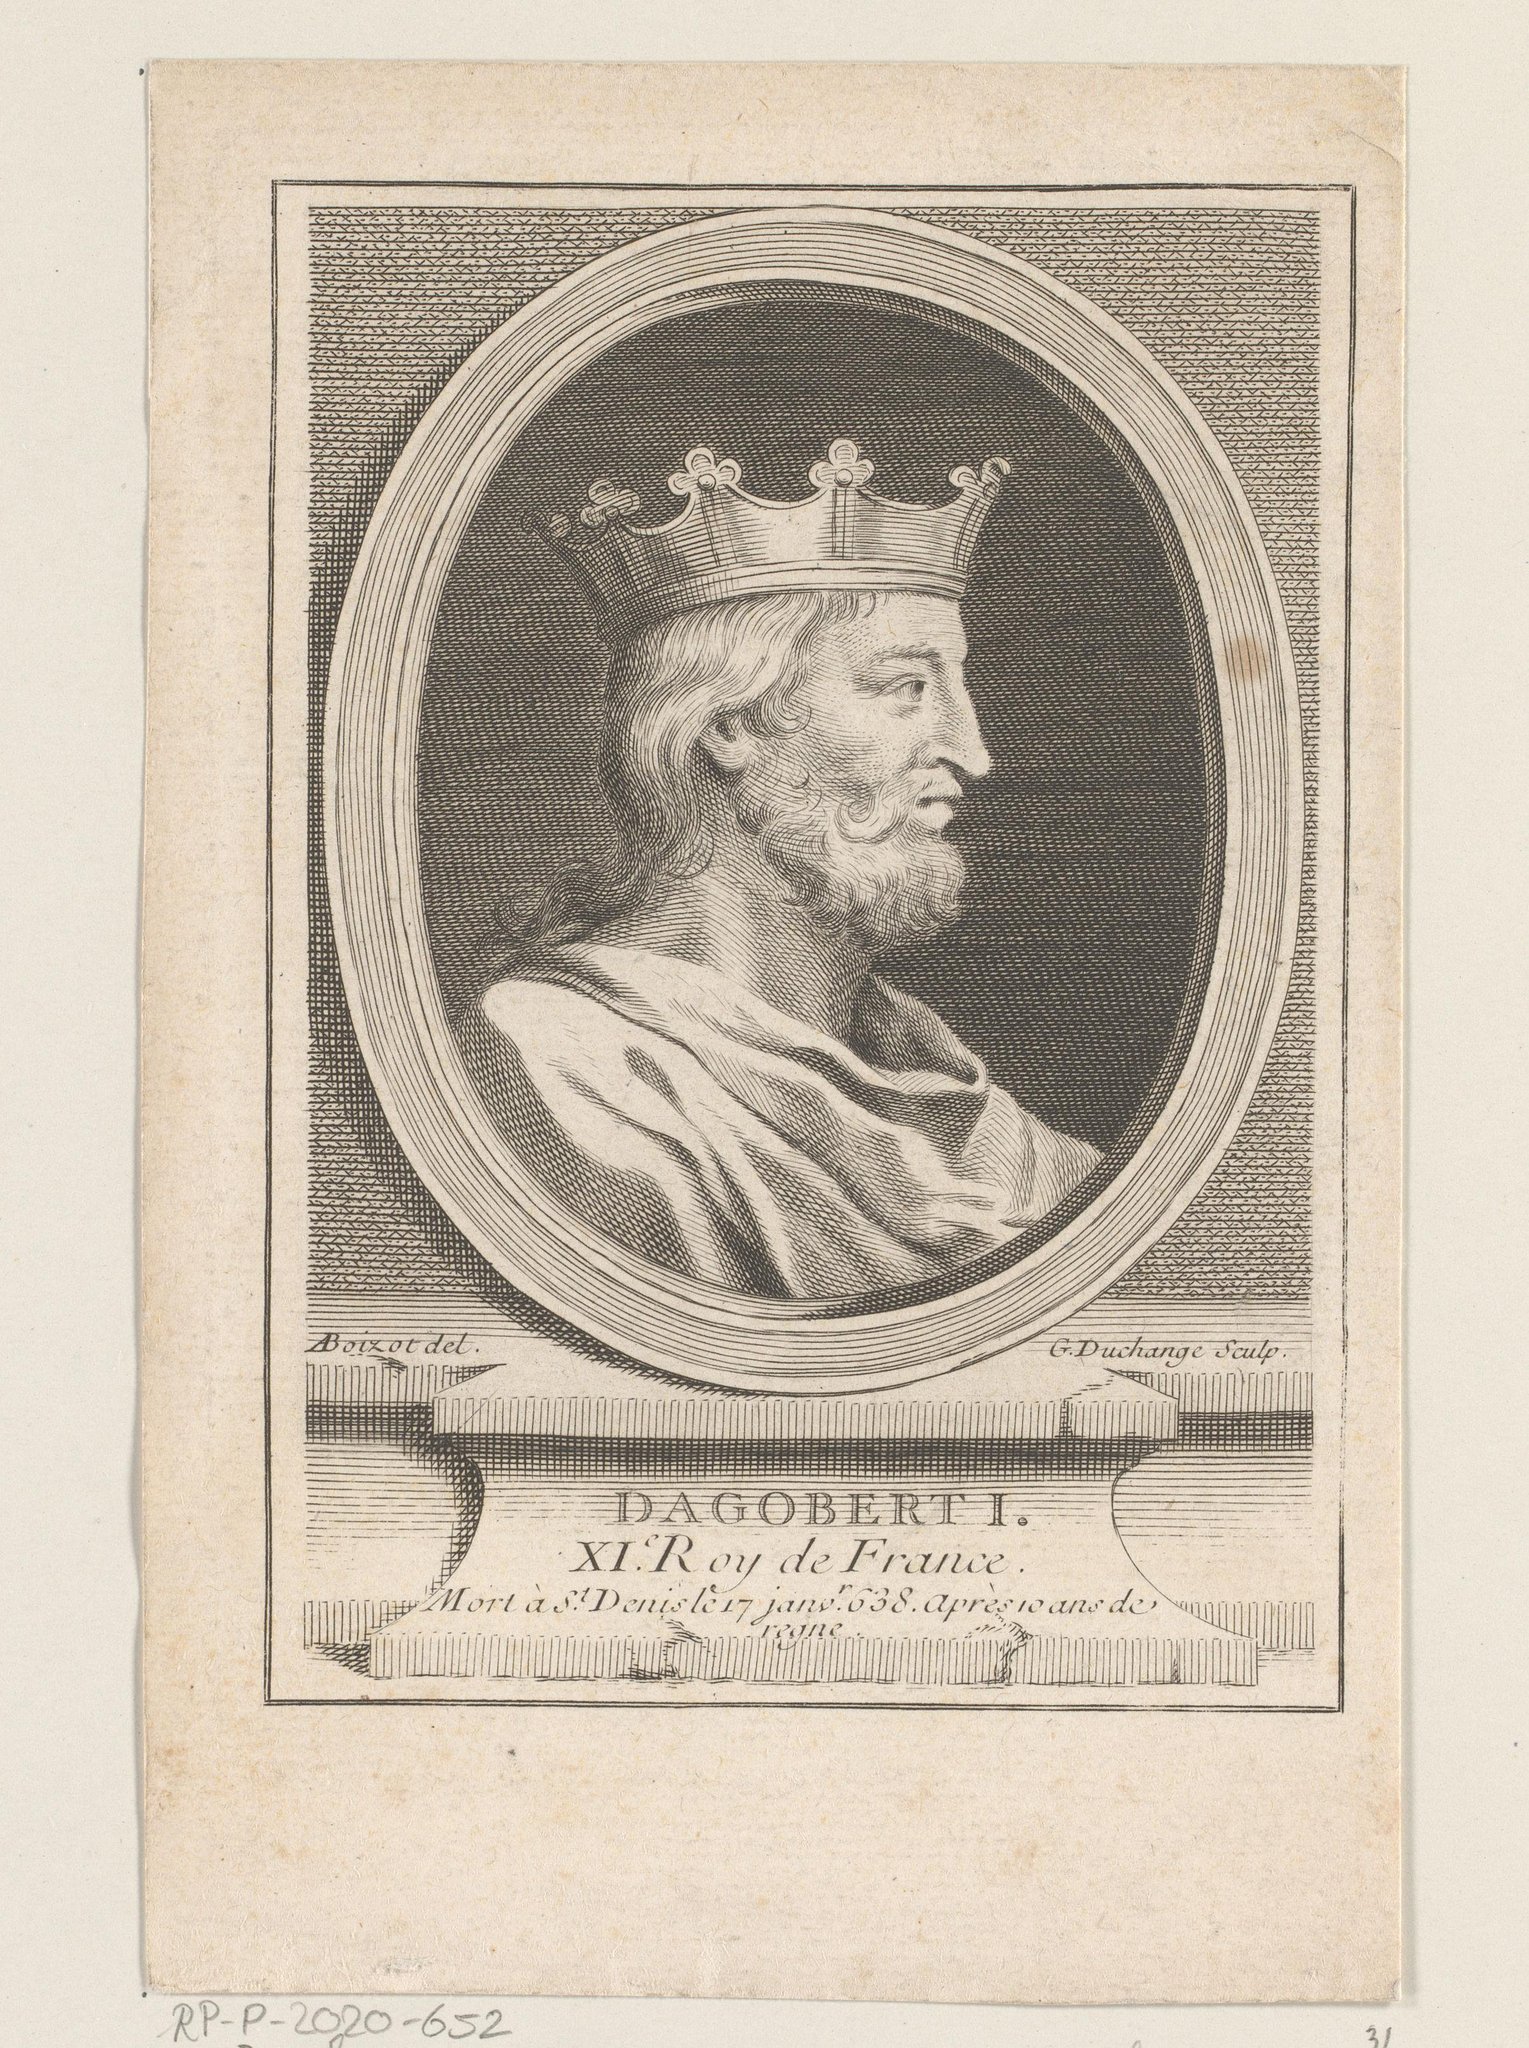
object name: book illustration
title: Portret van Dagobert I, koning der Franken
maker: gaspard duchange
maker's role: print maker, publisher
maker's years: 1662-1757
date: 1710-1757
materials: paper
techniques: engraving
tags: historical persons, ruler, sovereign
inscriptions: collector's mark: Lugt 2228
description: Prent uit: Eudes de Mézeray, François. Histoire de France, depuis Faramond jusqu’au regne de Louis le Juste (...). 3 dln. Parijs: Denis Thierry, Jean Guignard en Claude Barbin, 1635, dl. 1. Prent waarschijnlijk voor het eerst verschenen in: Bie, Jacques de. Les vrais portraits des rois de France (...). Parijs: Jacques de Bie en Pierre Rocolet, 1634. Prent ook gebruikt in latere publicaties.